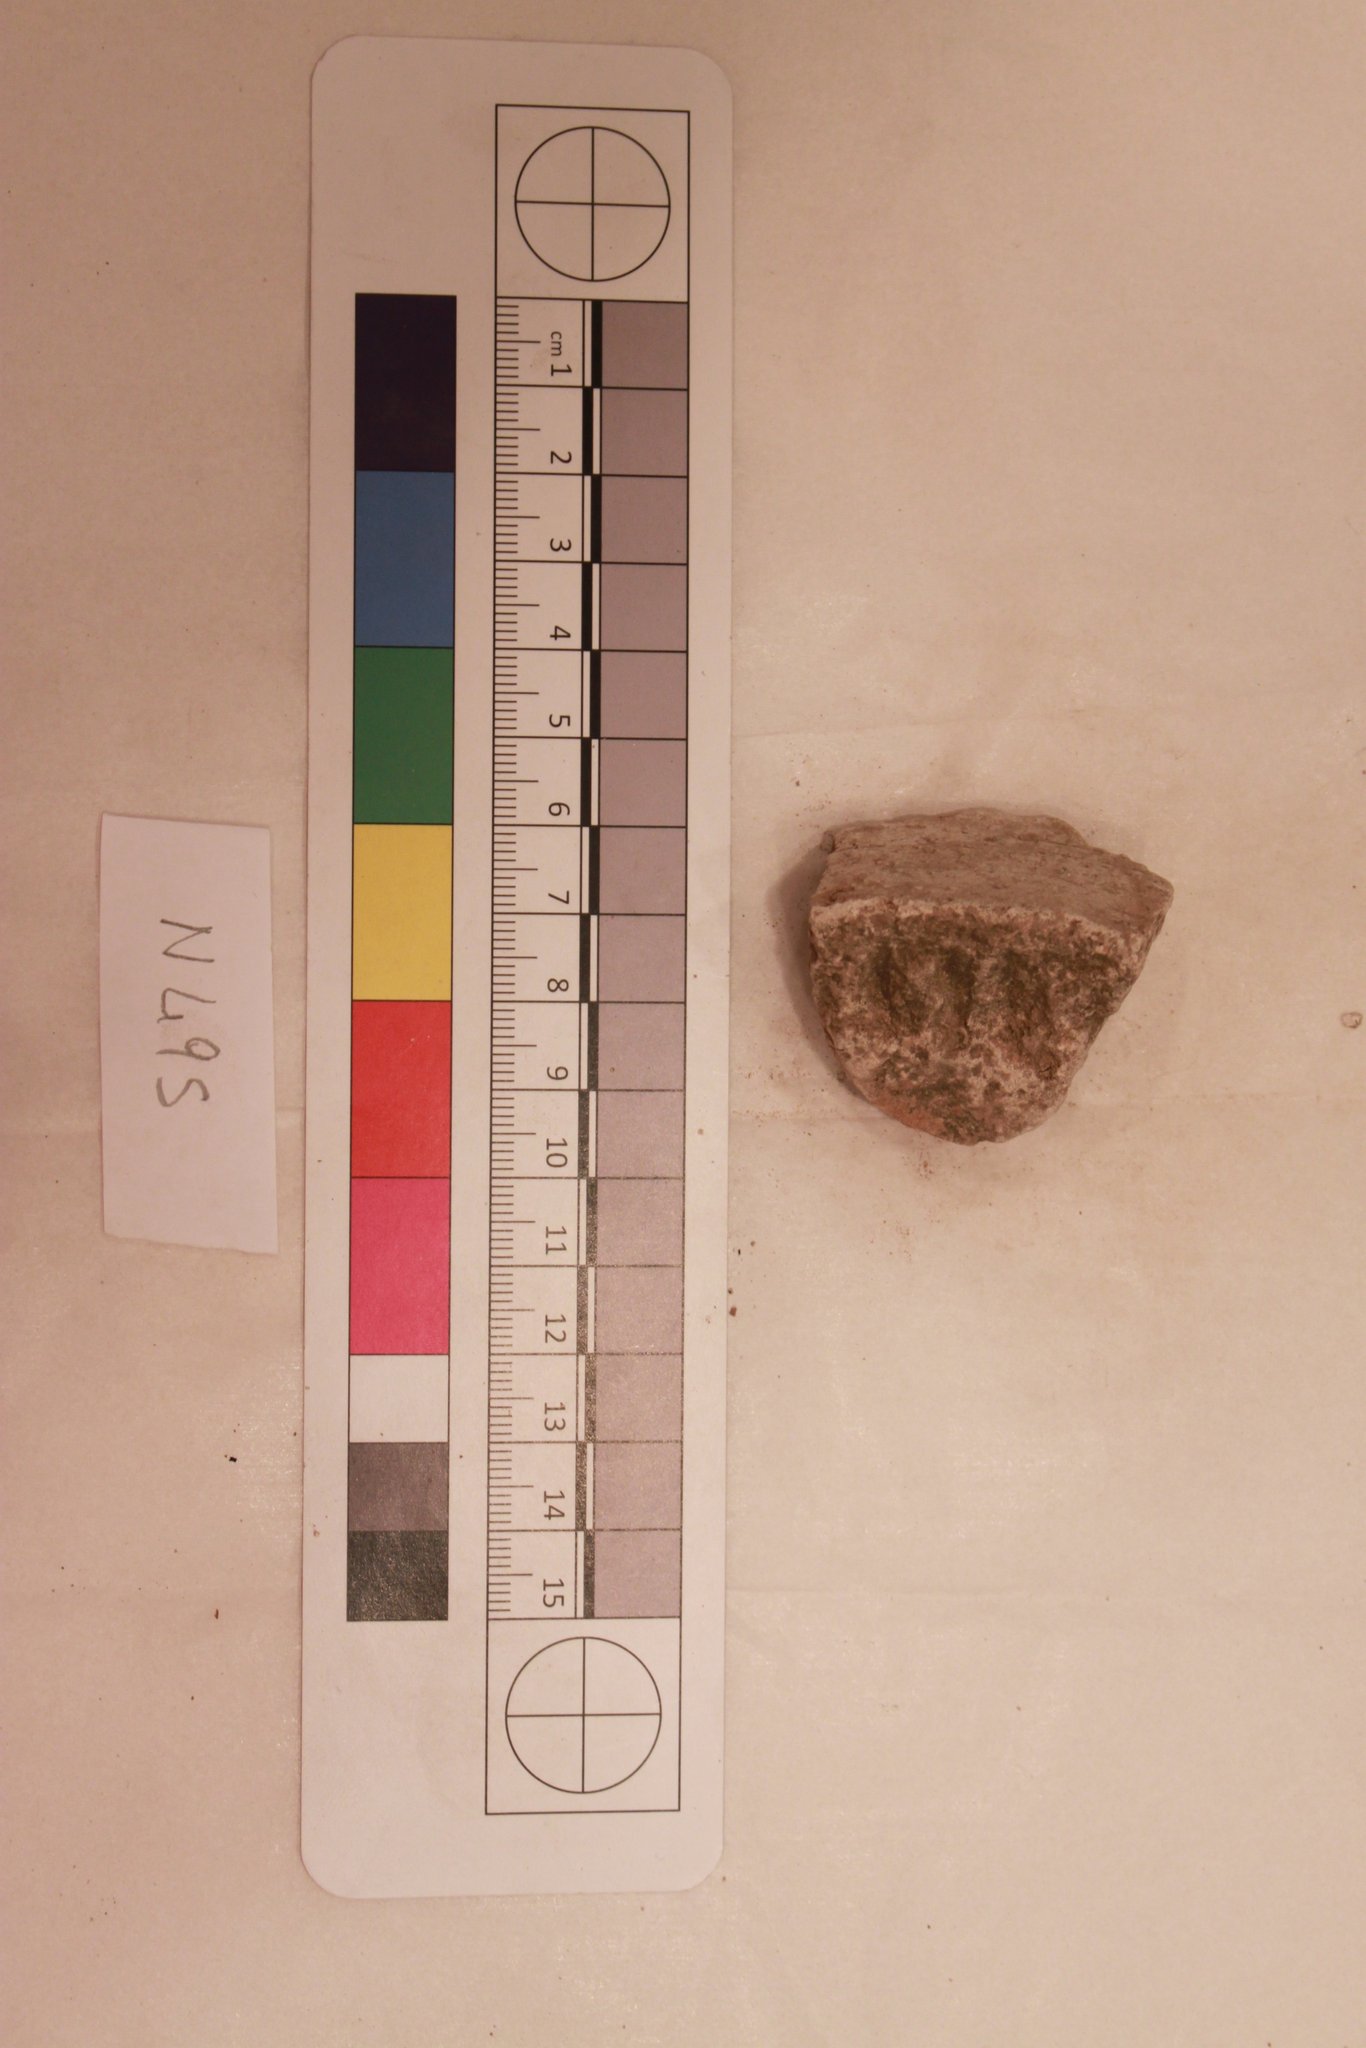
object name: fragment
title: Stucco Fragment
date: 701-1200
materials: plaster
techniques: carving, painting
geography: iran